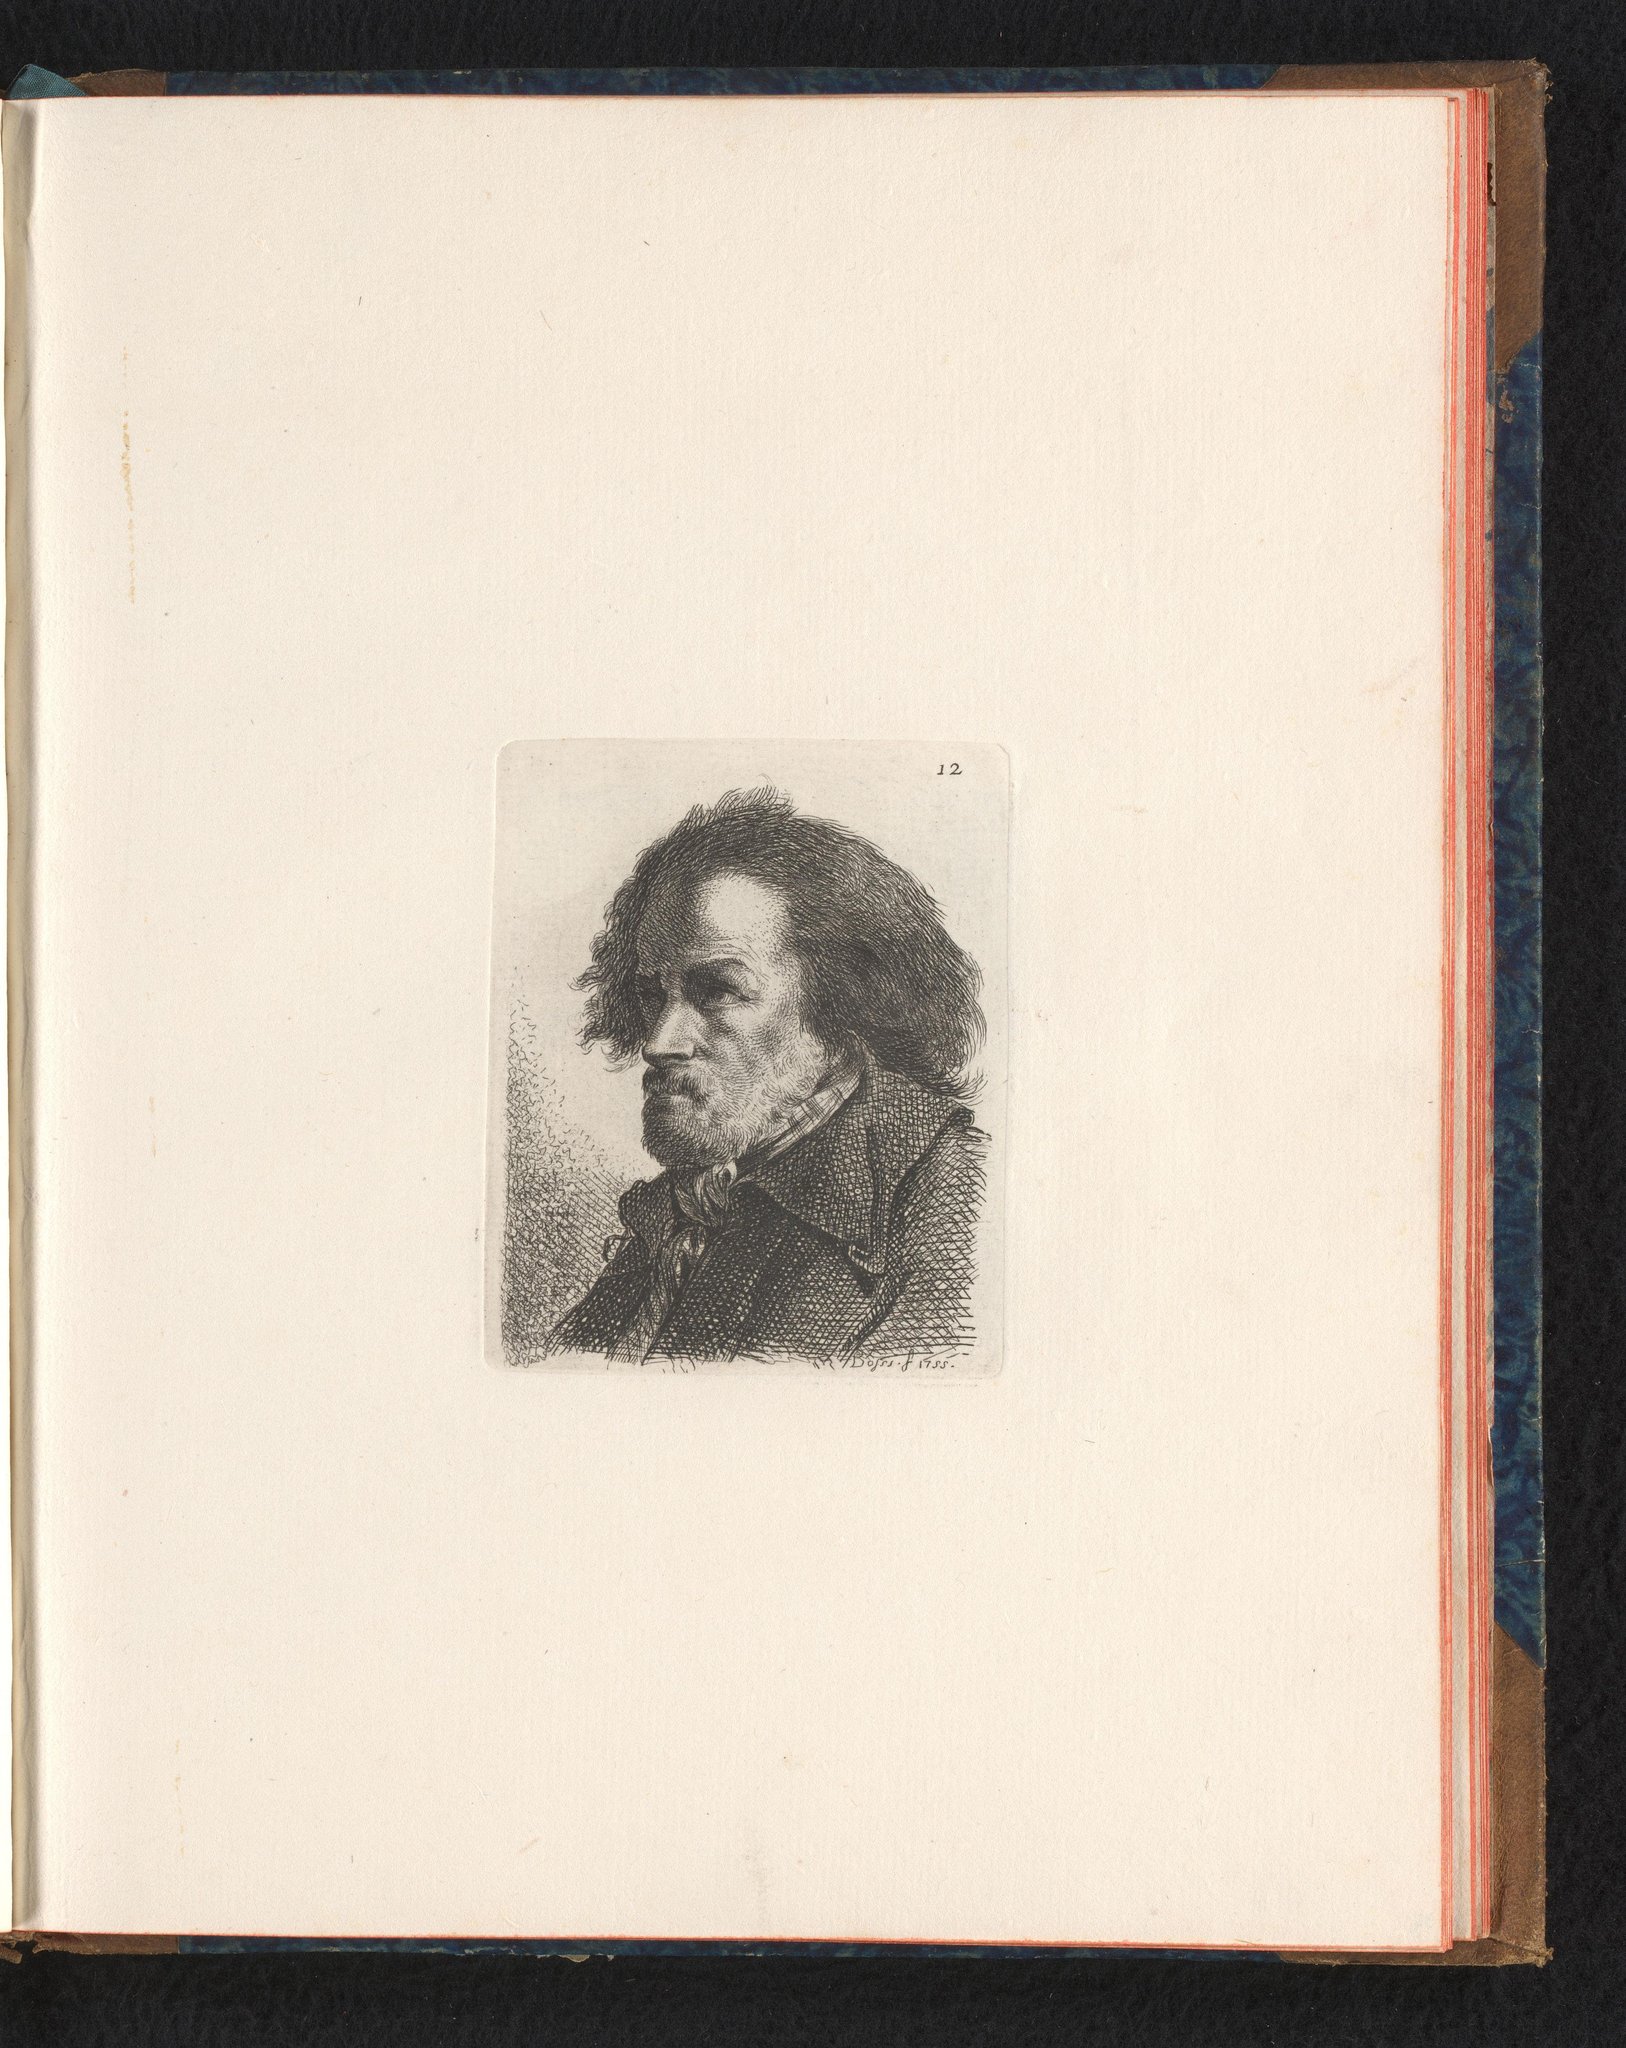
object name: print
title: Verzameling van hoofden, gedachten, trofeeën en diverse etsen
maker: benigno bossi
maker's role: print maker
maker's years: 1727-1792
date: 1755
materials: paper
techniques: etching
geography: parma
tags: head (human)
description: De prent is waarschijnlijk in de eerste staat uitgegeven onder de serietitel: Prove d"aqua forte. De prent is in de tweede staat ook uitgegeven onder de serietitel: Raccolta di teste inventate, disegnate ed incise da Benigno Bossi.